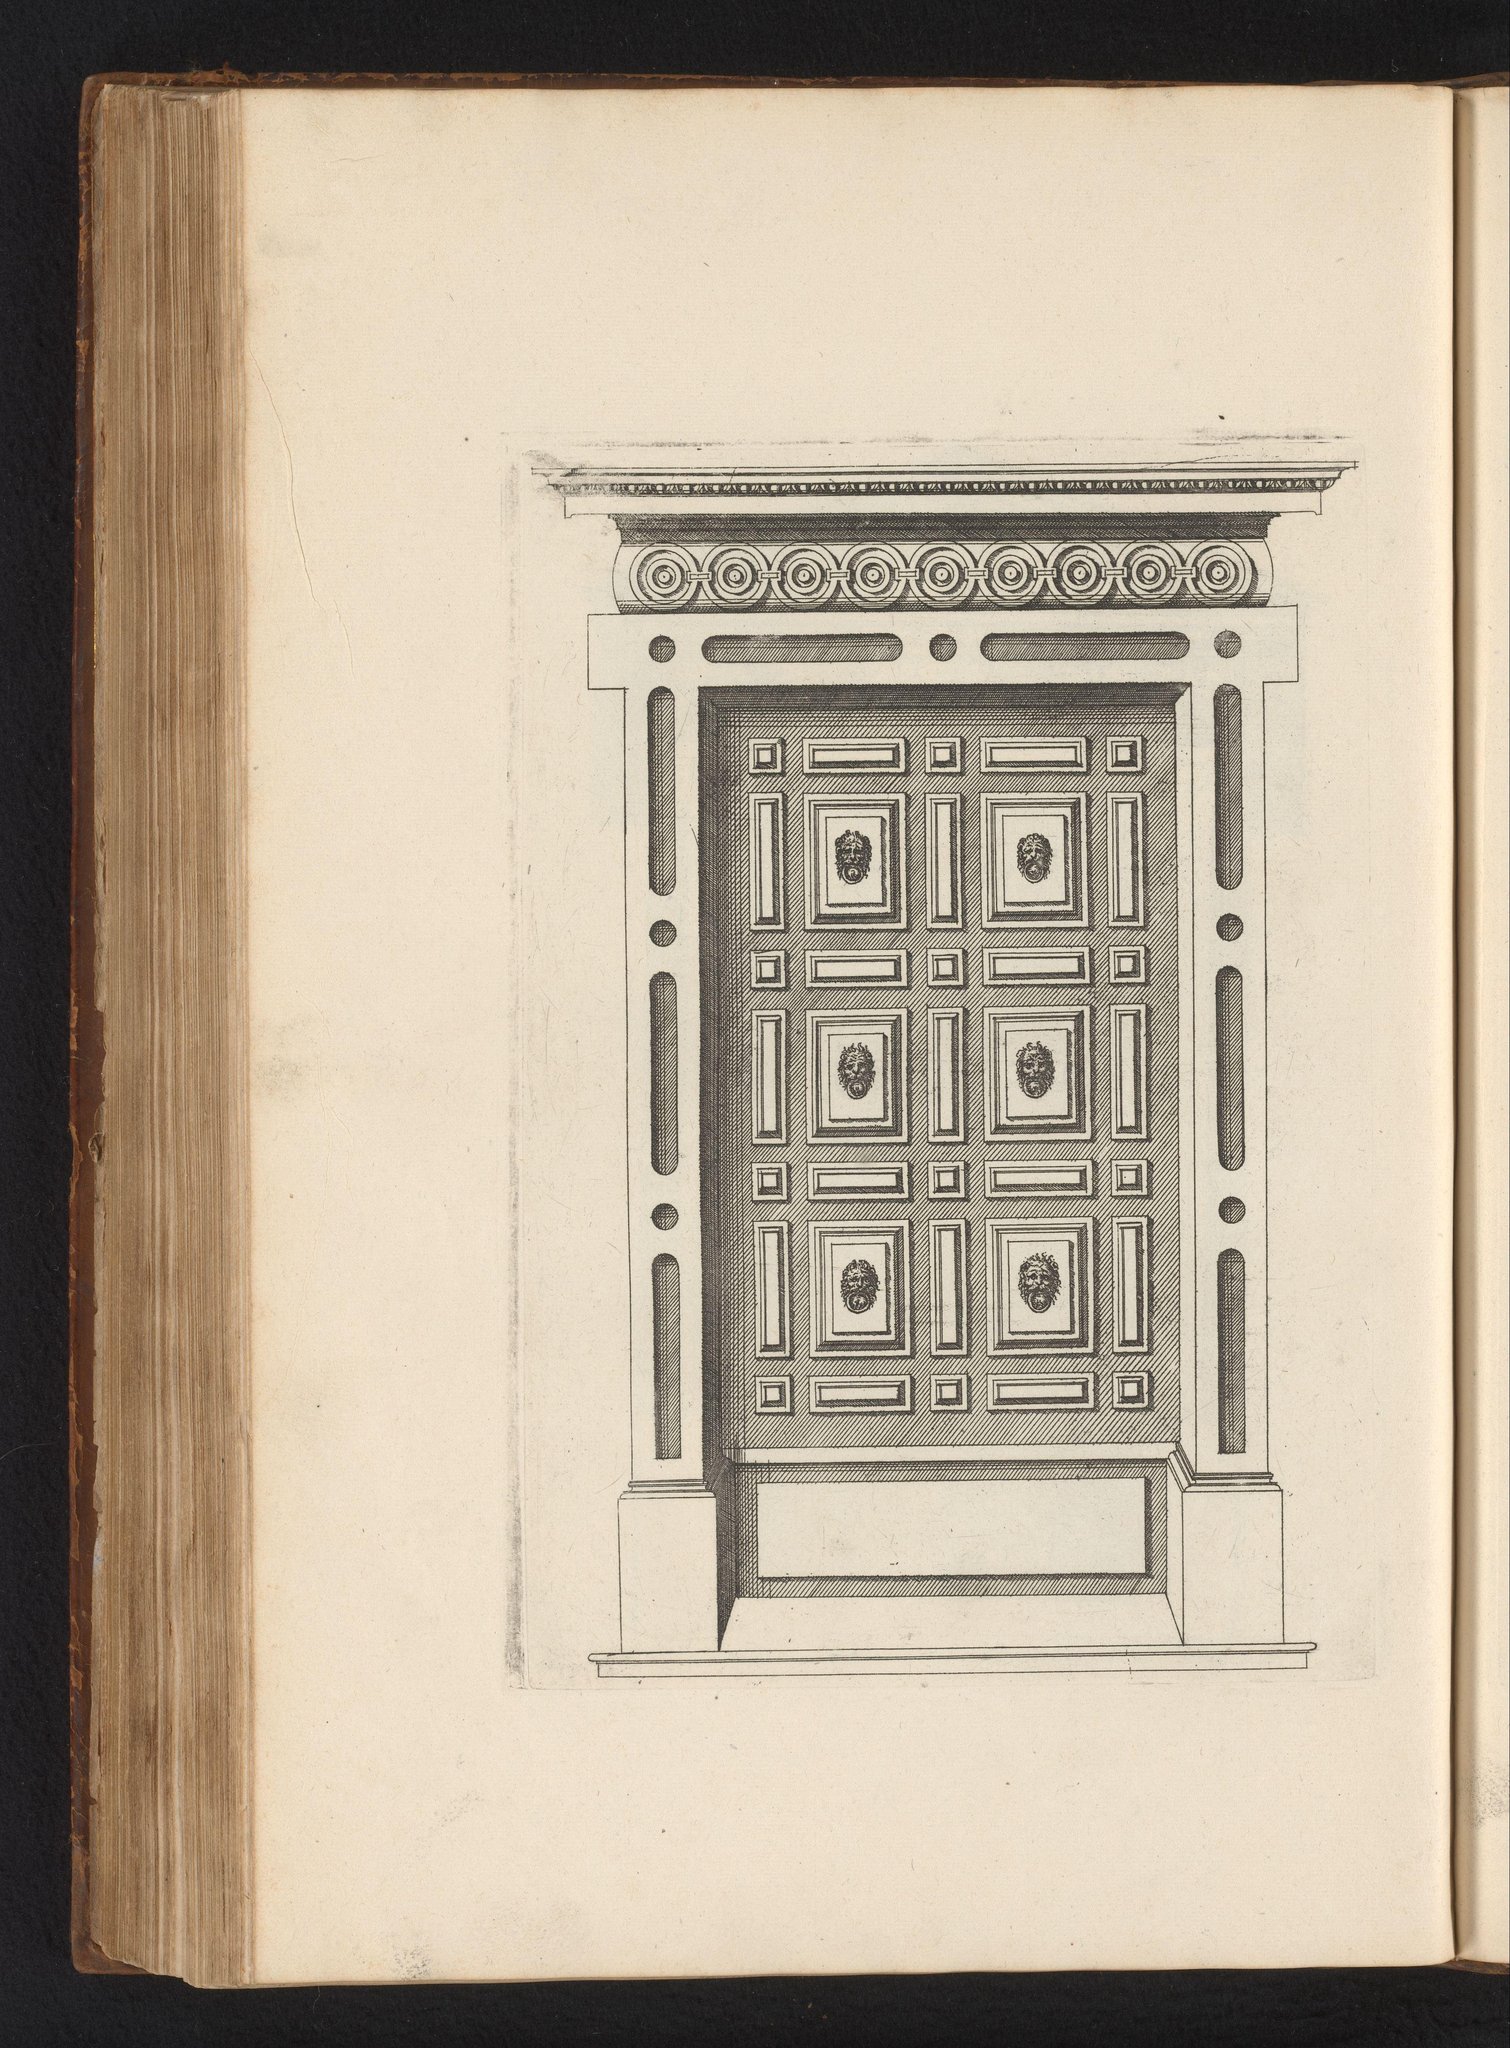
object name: ornament print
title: Deur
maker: jacques androuet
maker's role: draughtsman, print maker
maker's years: 1515-1584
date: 1561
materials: paper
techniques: etching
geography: paris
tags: door-knocker, doorbell, door, architectural design or model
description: Deur met deurkloppers in de vorm van een leeuwenkop. Onderdeel van 'Seconde livre d'architectvre' (1561): 64 etsen met geornamenteerde architectuuronderdelen.